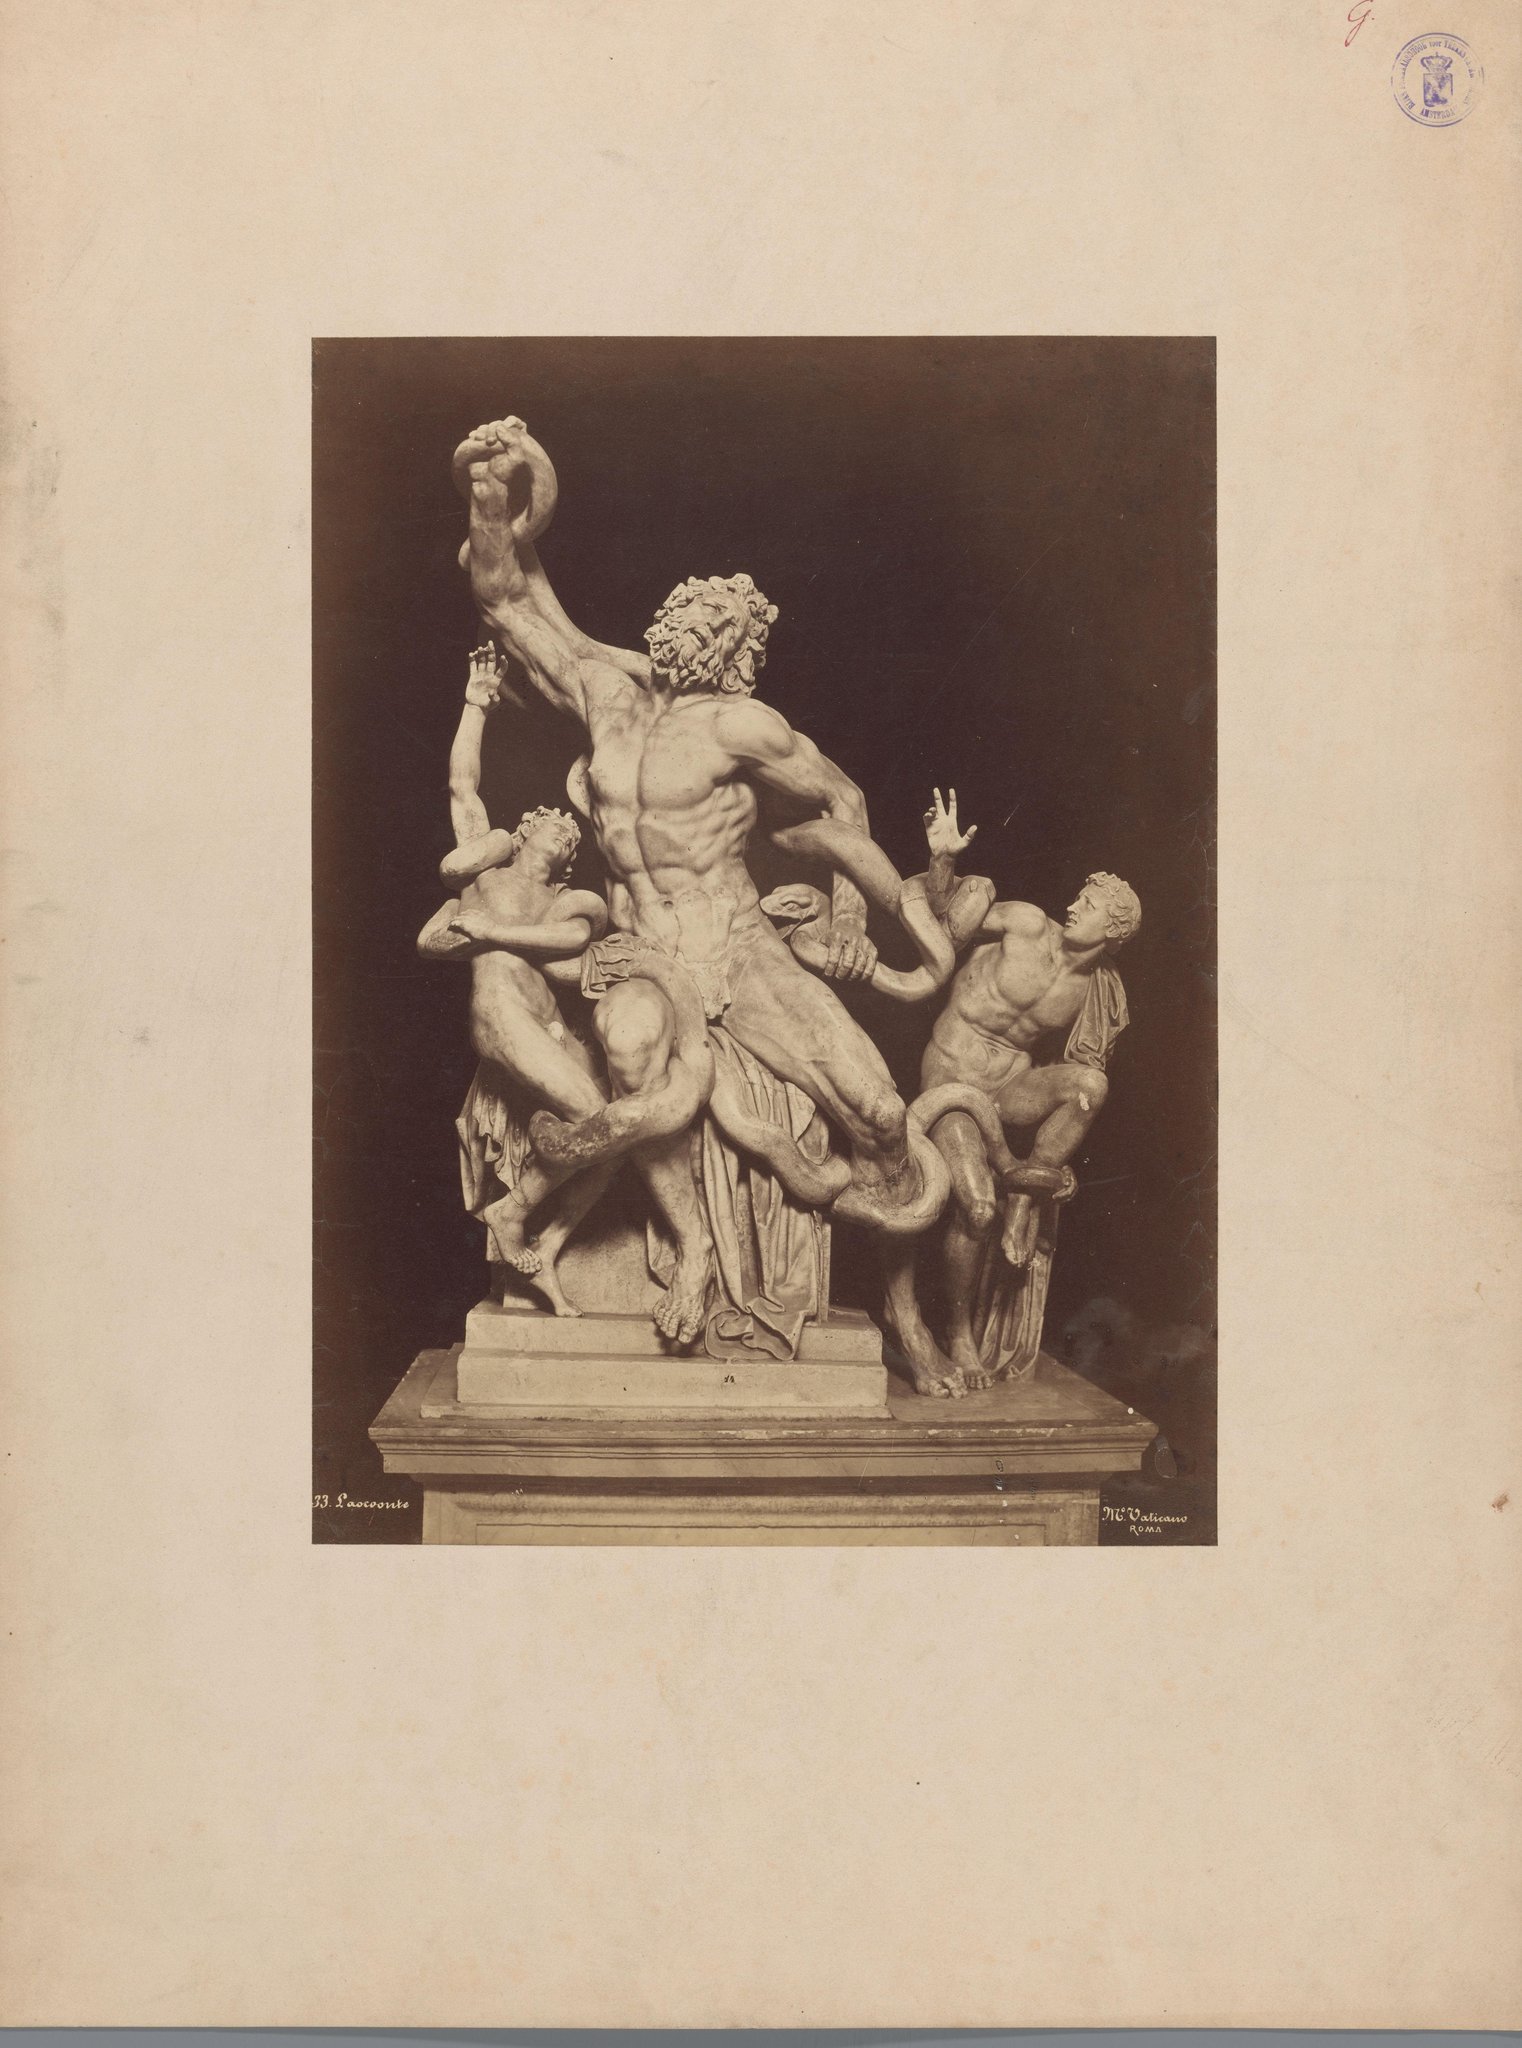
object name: photograph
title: Laocoonte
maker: Anonymous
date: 1880-1900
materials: cardboard, paper, photographic support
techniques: albumen print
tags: vaticaanse musea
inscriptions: stamp, : ‘33. Laocoonte Mo Vaticano / ROMA’